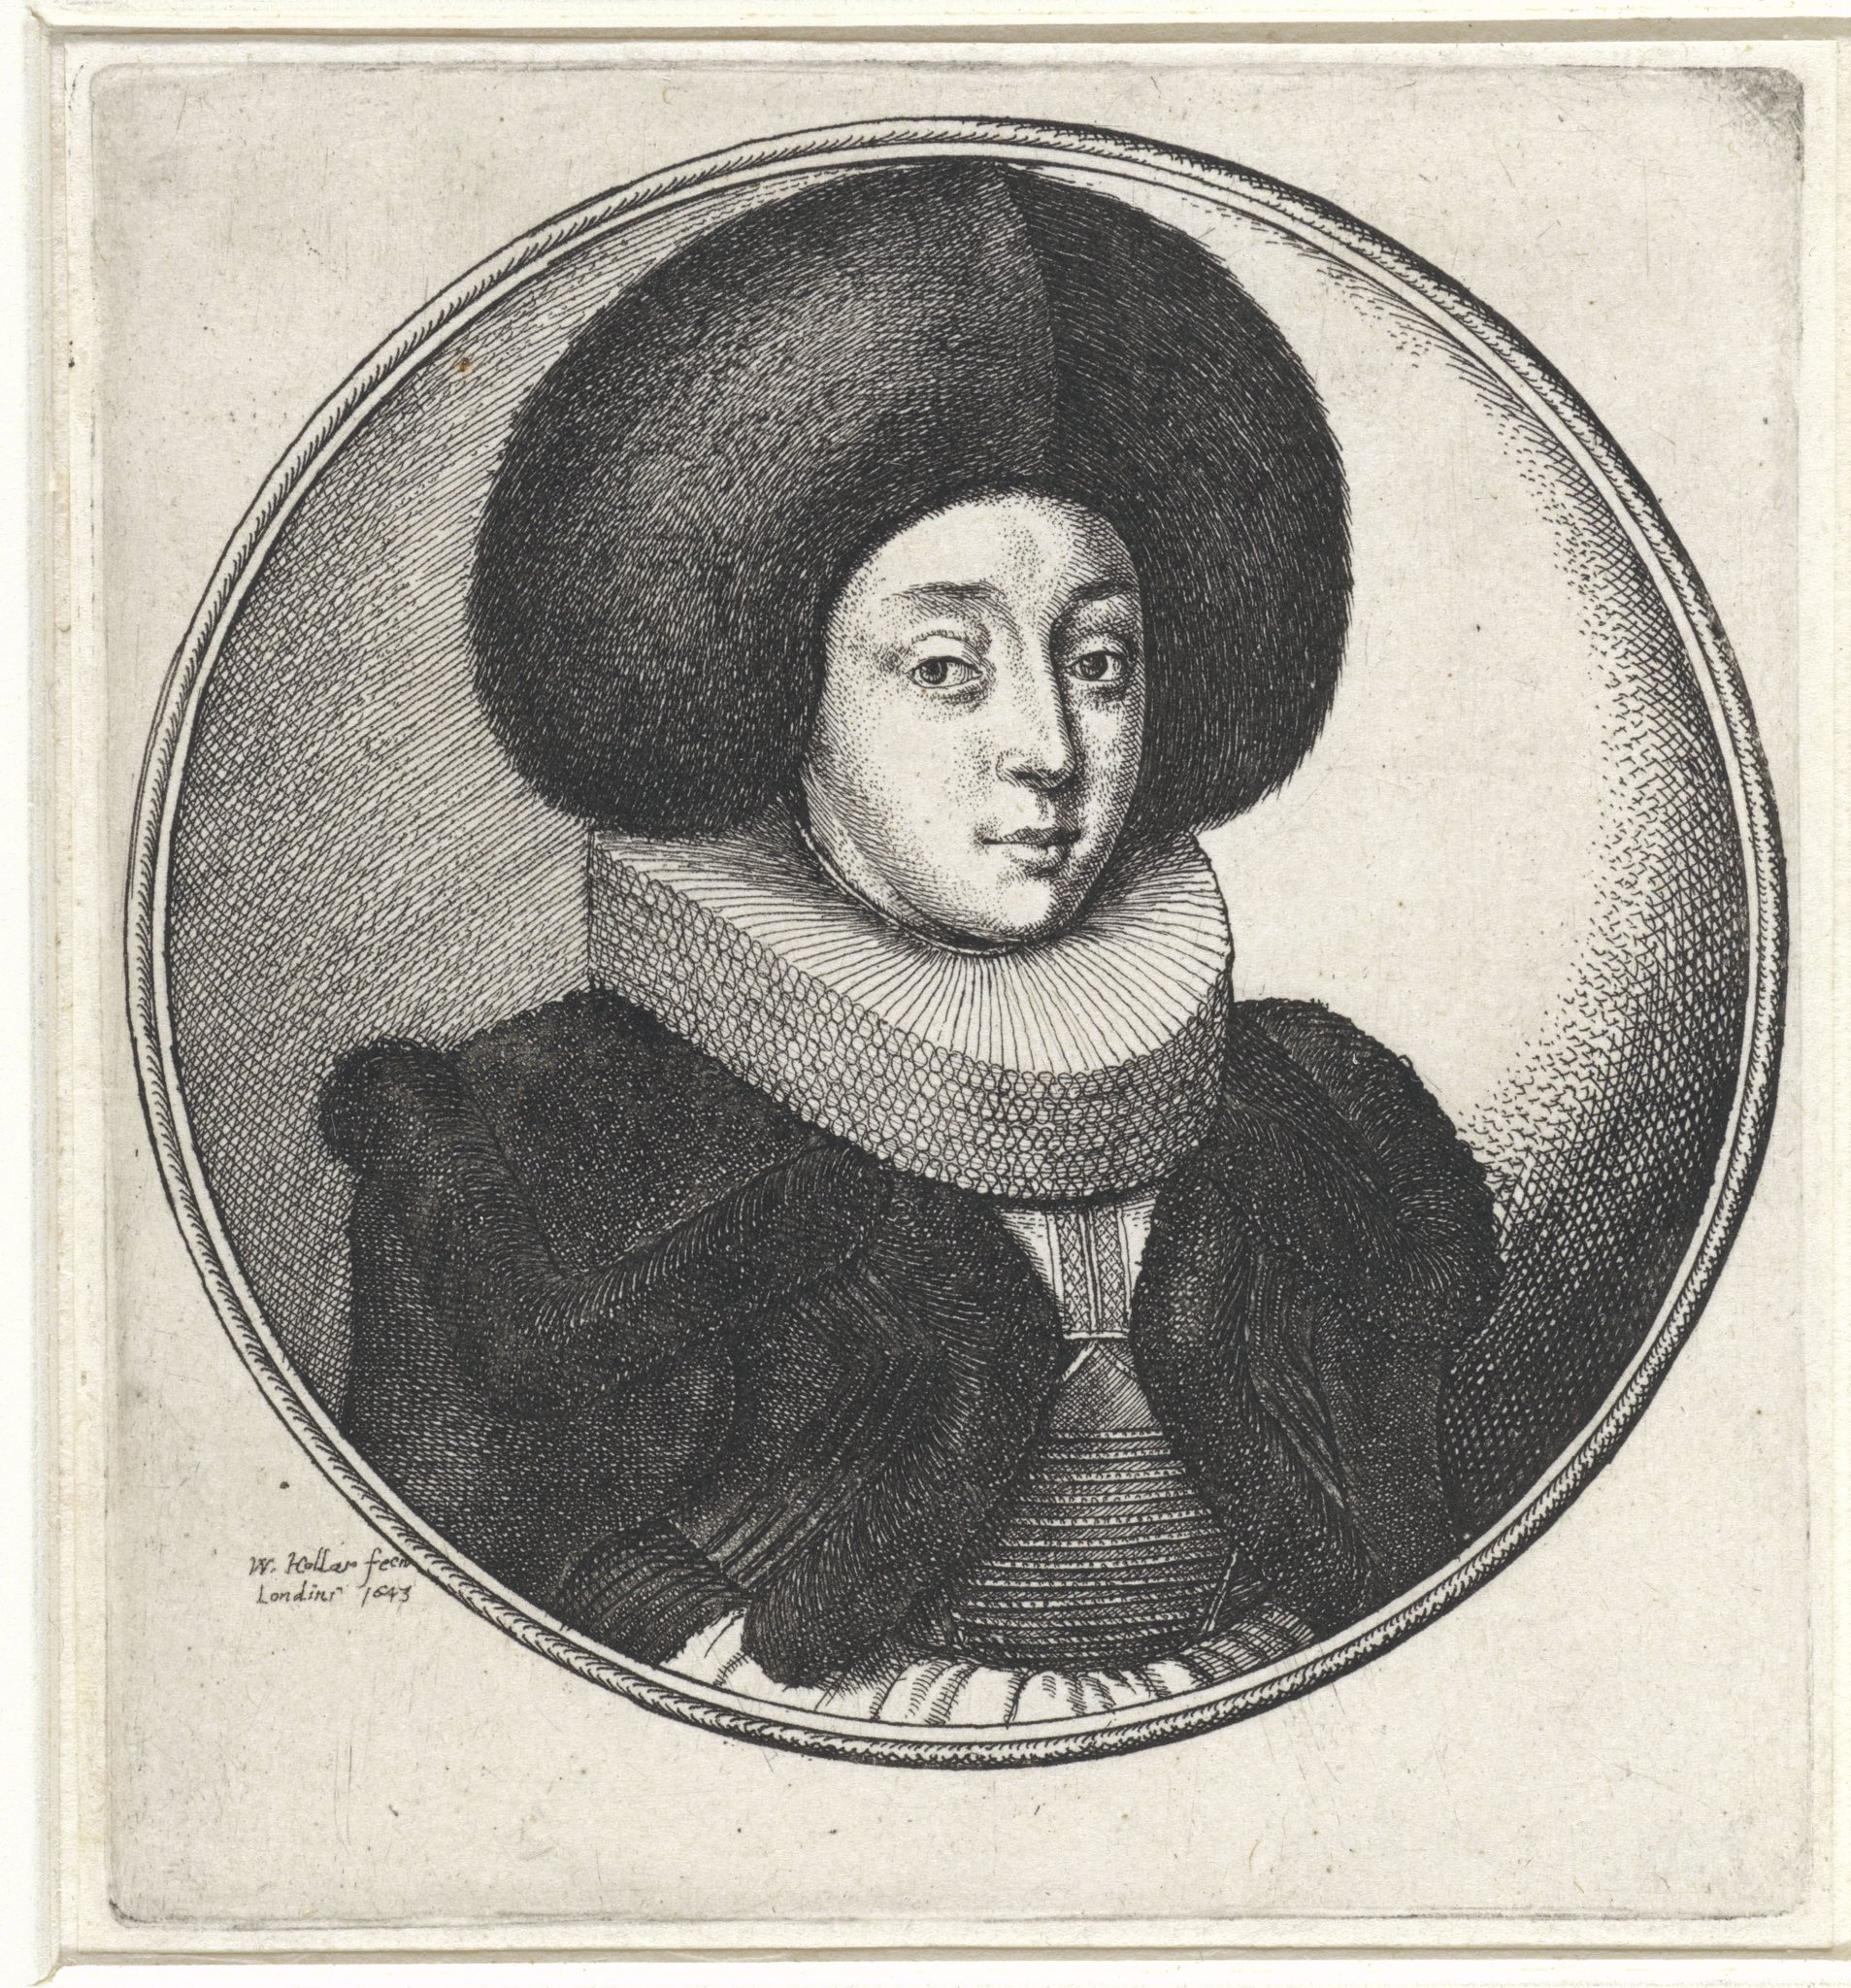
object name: print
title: Medaillons met vrouwenbusten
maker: wenceslaus hollar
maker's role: draughtsman, print maker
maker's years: 1607-1677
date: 1643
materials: paper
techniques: etching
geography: london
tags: head-gear (fur cap) (+ women's clothes), anonymous historical person portrayed alone - bb - woman, neck-gear ~ clothing (with name) (+ women's clothes)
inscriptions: collector's mark: Lugt 654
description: De prent maakt deel uit van een 13-delige serie met vrouwenbusten in medaillons.